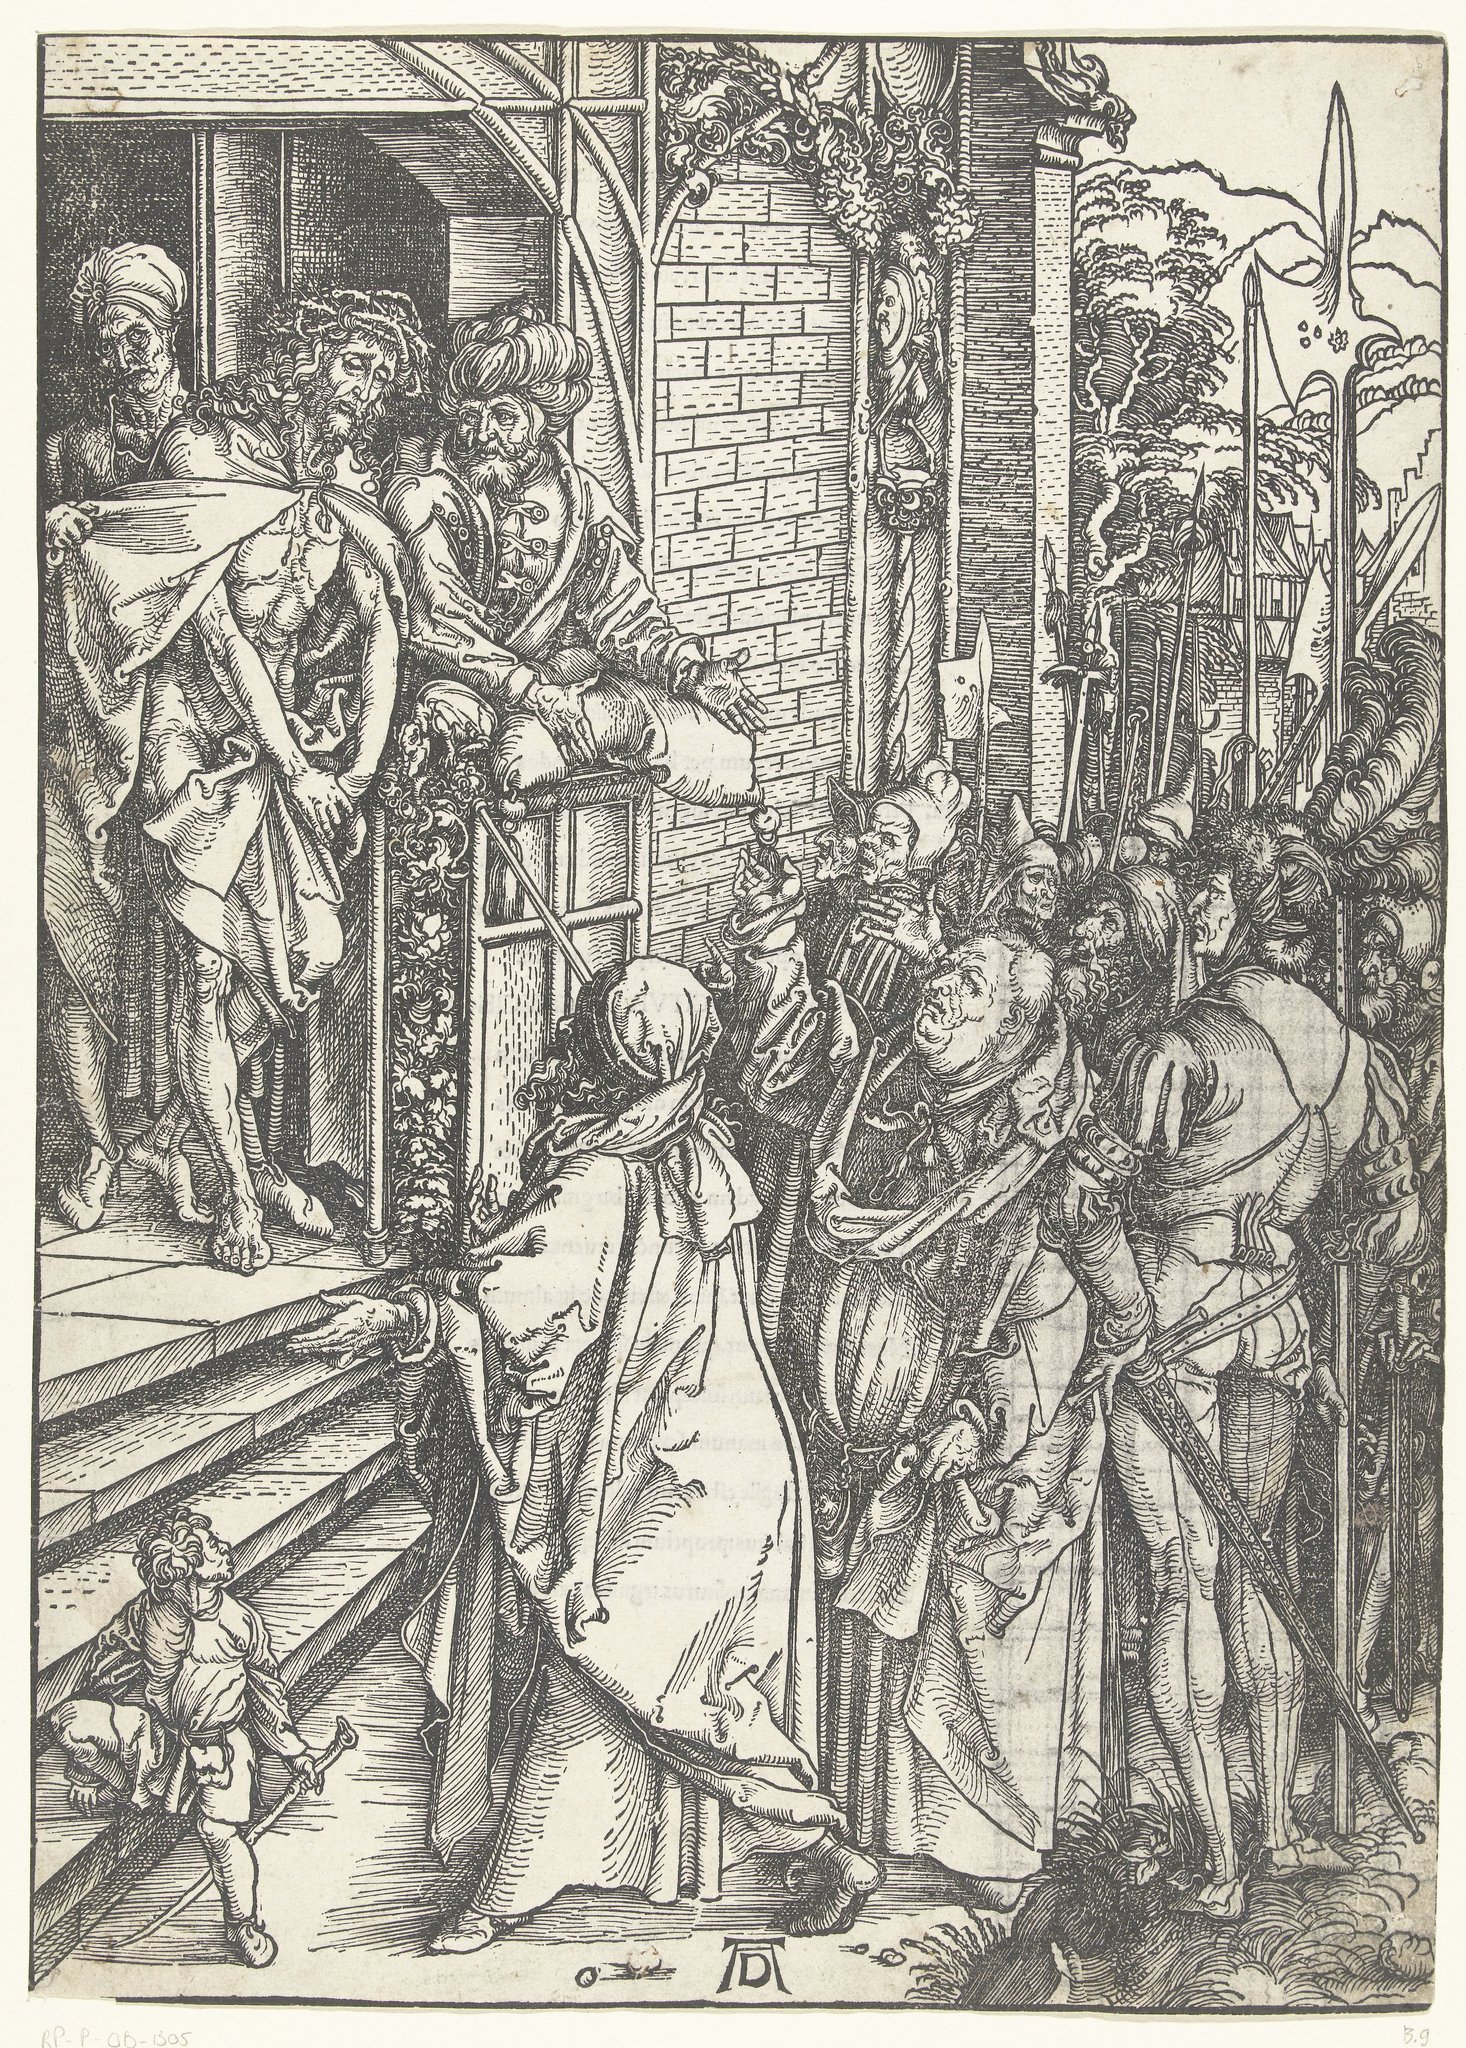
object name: print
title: Christus aan het volk getoond (Ecce homo)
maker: albrecht dürer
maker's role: draughtsman, painter, print maker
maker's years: 1471-1528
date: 1498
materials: paper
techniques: letterpress printing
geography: nuremberg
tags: pilate showing christ to the people, 'ostentatio christi', 'ecce homo' (john 19:4-6)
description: Christus wordt, staand op een bordes, aan een joelende menigte mensen (onder wie veel soldaten) getoond. Op versozijde gedrukte Latijnse tekst. Deze prent is onderdeel van de prentserie 'De grote Passie', bestaande uit een titelprent en 11 scènes uit het Lijdensverhaal.